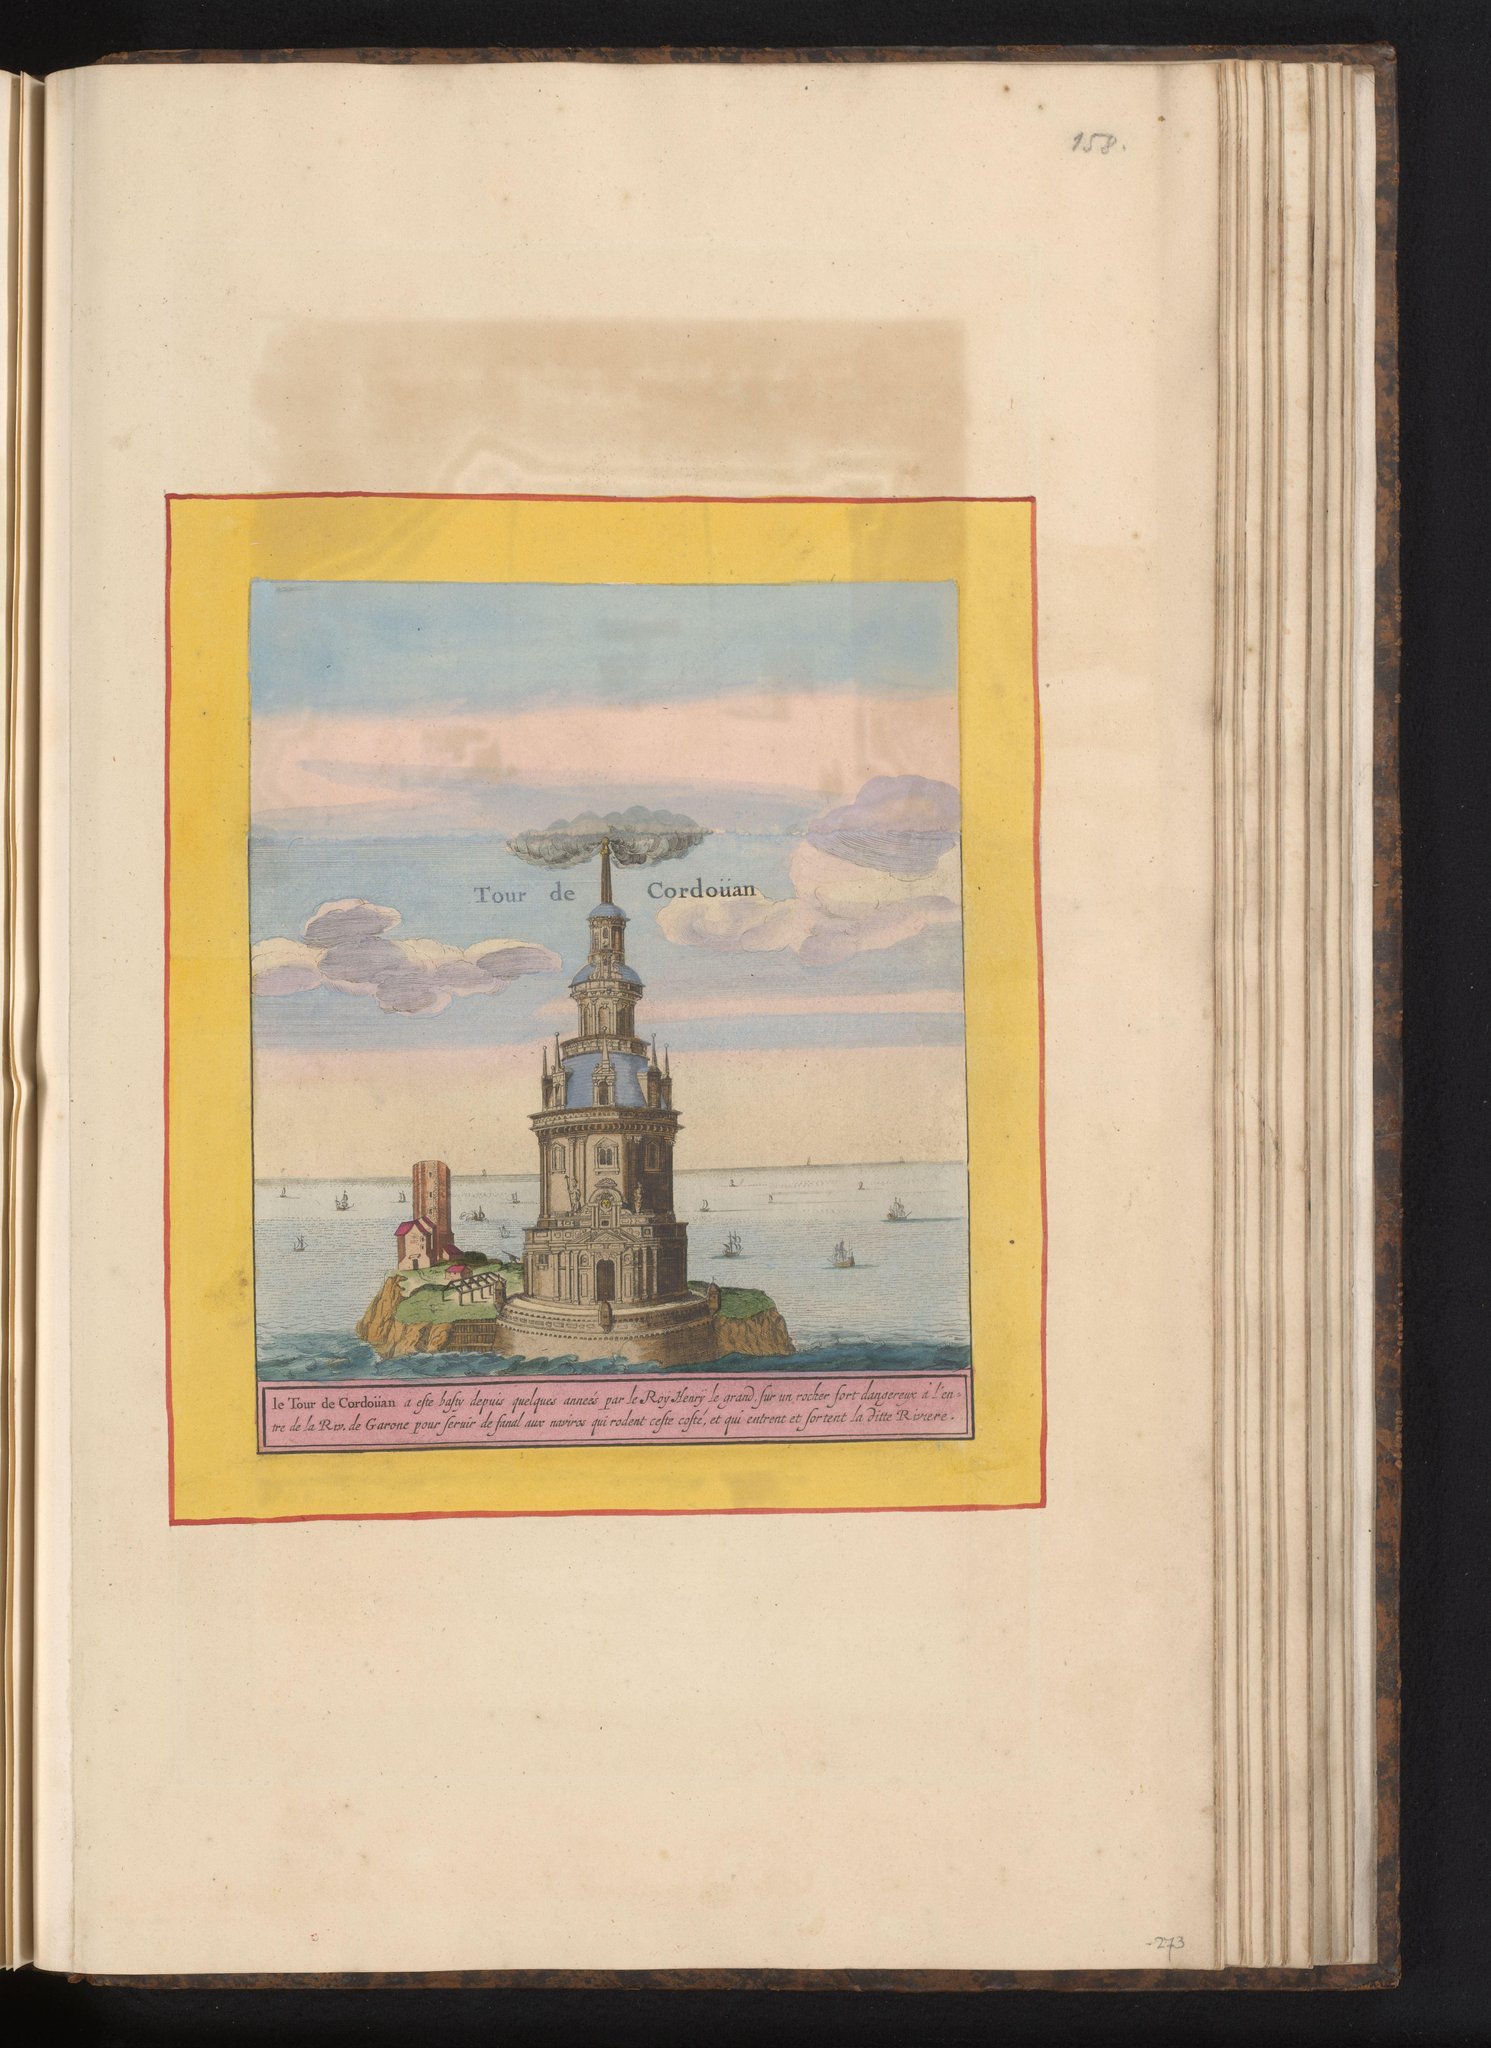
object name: album leaf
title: Gezicht op de vuurtoren van Cordouan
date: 1650-1699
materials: paper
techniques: engraving, hand coloring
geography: the hague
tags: lighthouse, lightship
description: Deze prent maakt deel uit van een album.